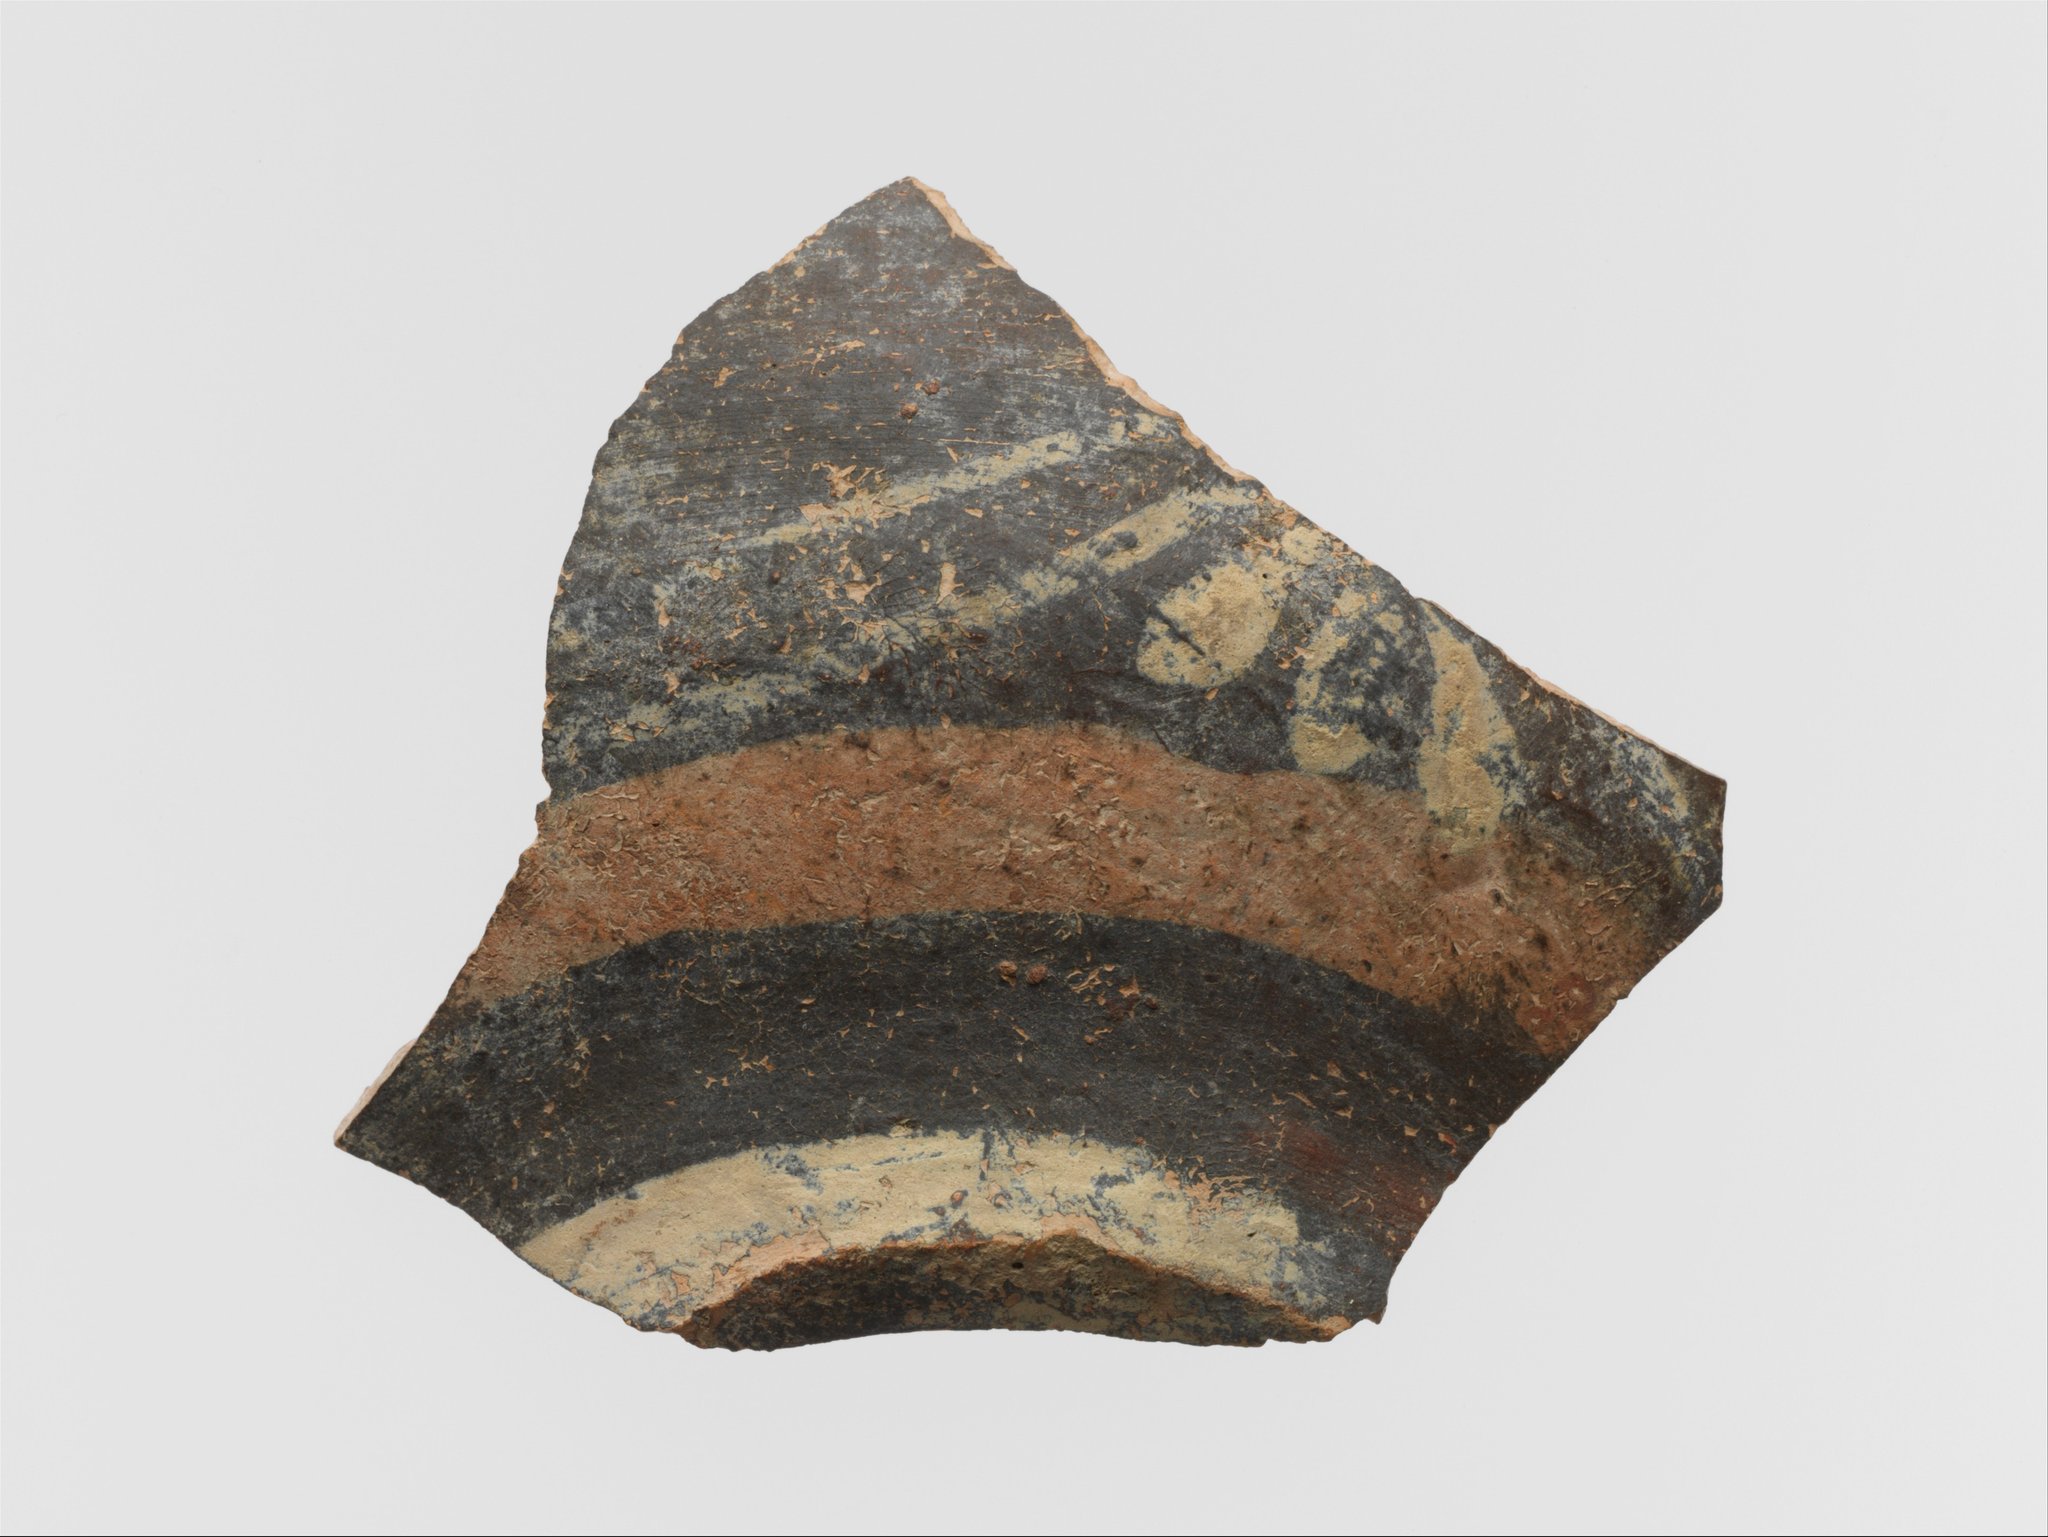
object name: vase fragment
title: Terracotta vase fragment with floral decoration and bands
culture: minoan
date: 1800-1700 BCE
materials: terracotta